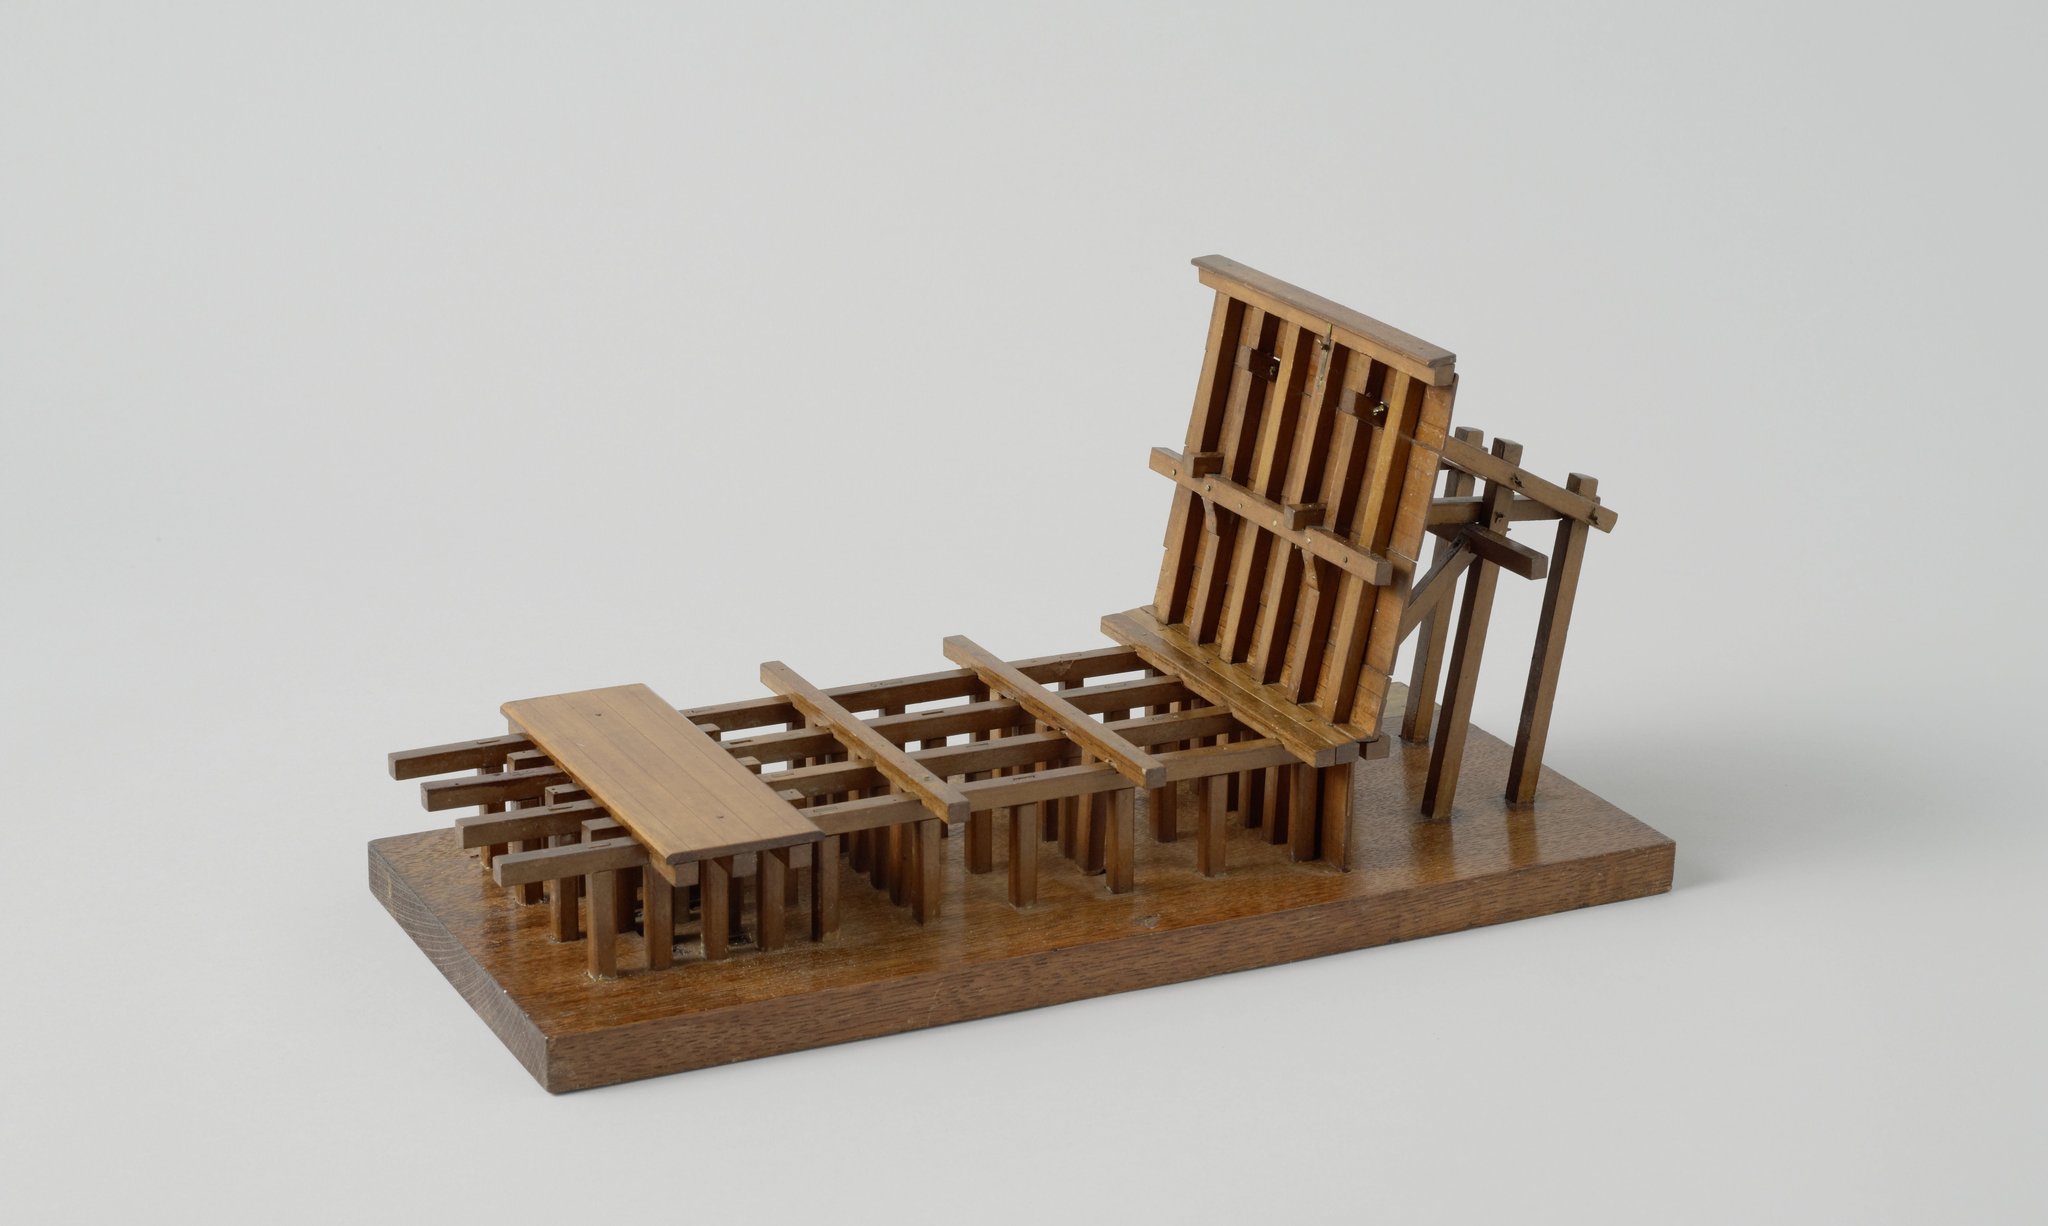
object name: demonstration model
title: Model of Part of the Timbering of the Dry Dock at Flushing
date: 1837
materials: brass, wood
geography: flushing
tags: flushing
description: Model van een gedeelte van de beschoeiing van een droogdok, waarop de hei-fundering en een gedeelte van de wand te zien is. Het droogdok in Vlissingen werd na veel uitstel hersteld in de jaren 1836-1837. Het model laat de toestand na deze reparaties zien.